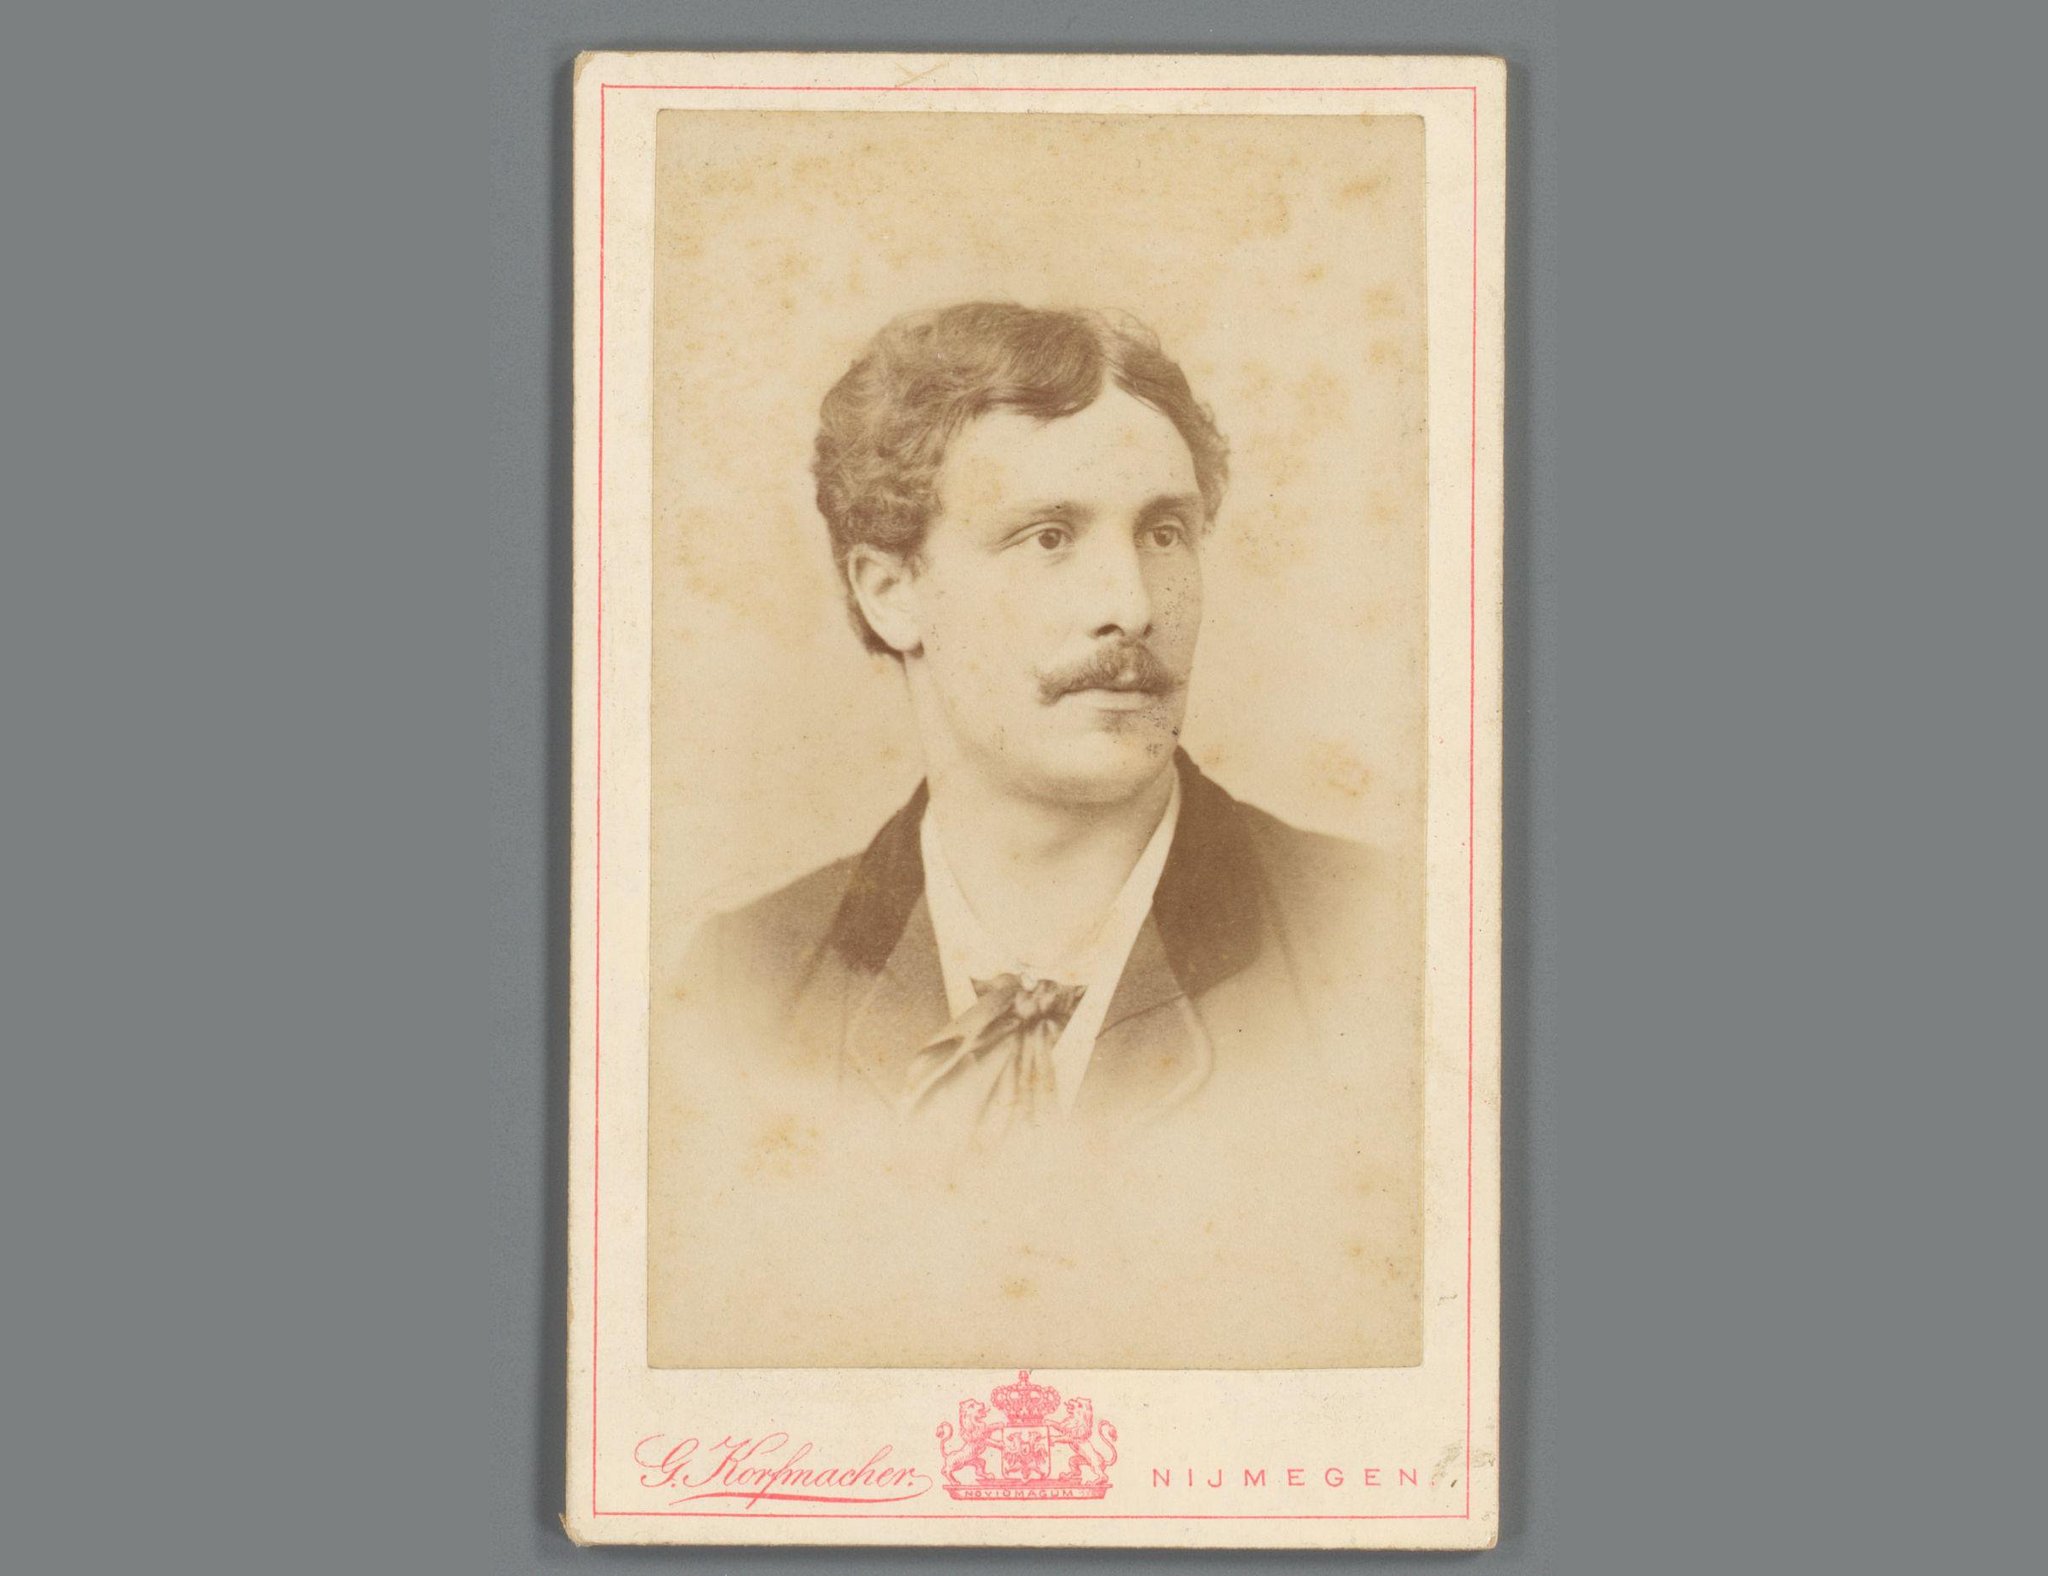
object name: carte de visite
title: Portret van een onbekende man met snor uit de familie en de kring van Eugene van Delden en Belle van Delden-Denninghof Stelling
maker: gerard karel martin hubert korfmacher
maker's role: fotograaf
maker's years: 1835-1914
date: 1878-1881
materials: cardboard, paper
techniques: albumen print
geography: nijmegen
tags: historical persons not known by name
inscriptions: inscription: ‘G Korfmacher/ Nijmegen/ Hoek Molenstraat B 678./ De plaat blijft tot nabestelling bewaard.’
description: Portret uit de kring van Eugene van Delden (Hartapoera, 1865 - Den Haag, 1954) en Belle van Delden-Denninghof Stelling (Batavia, 1870 - Den Haag, 1947).